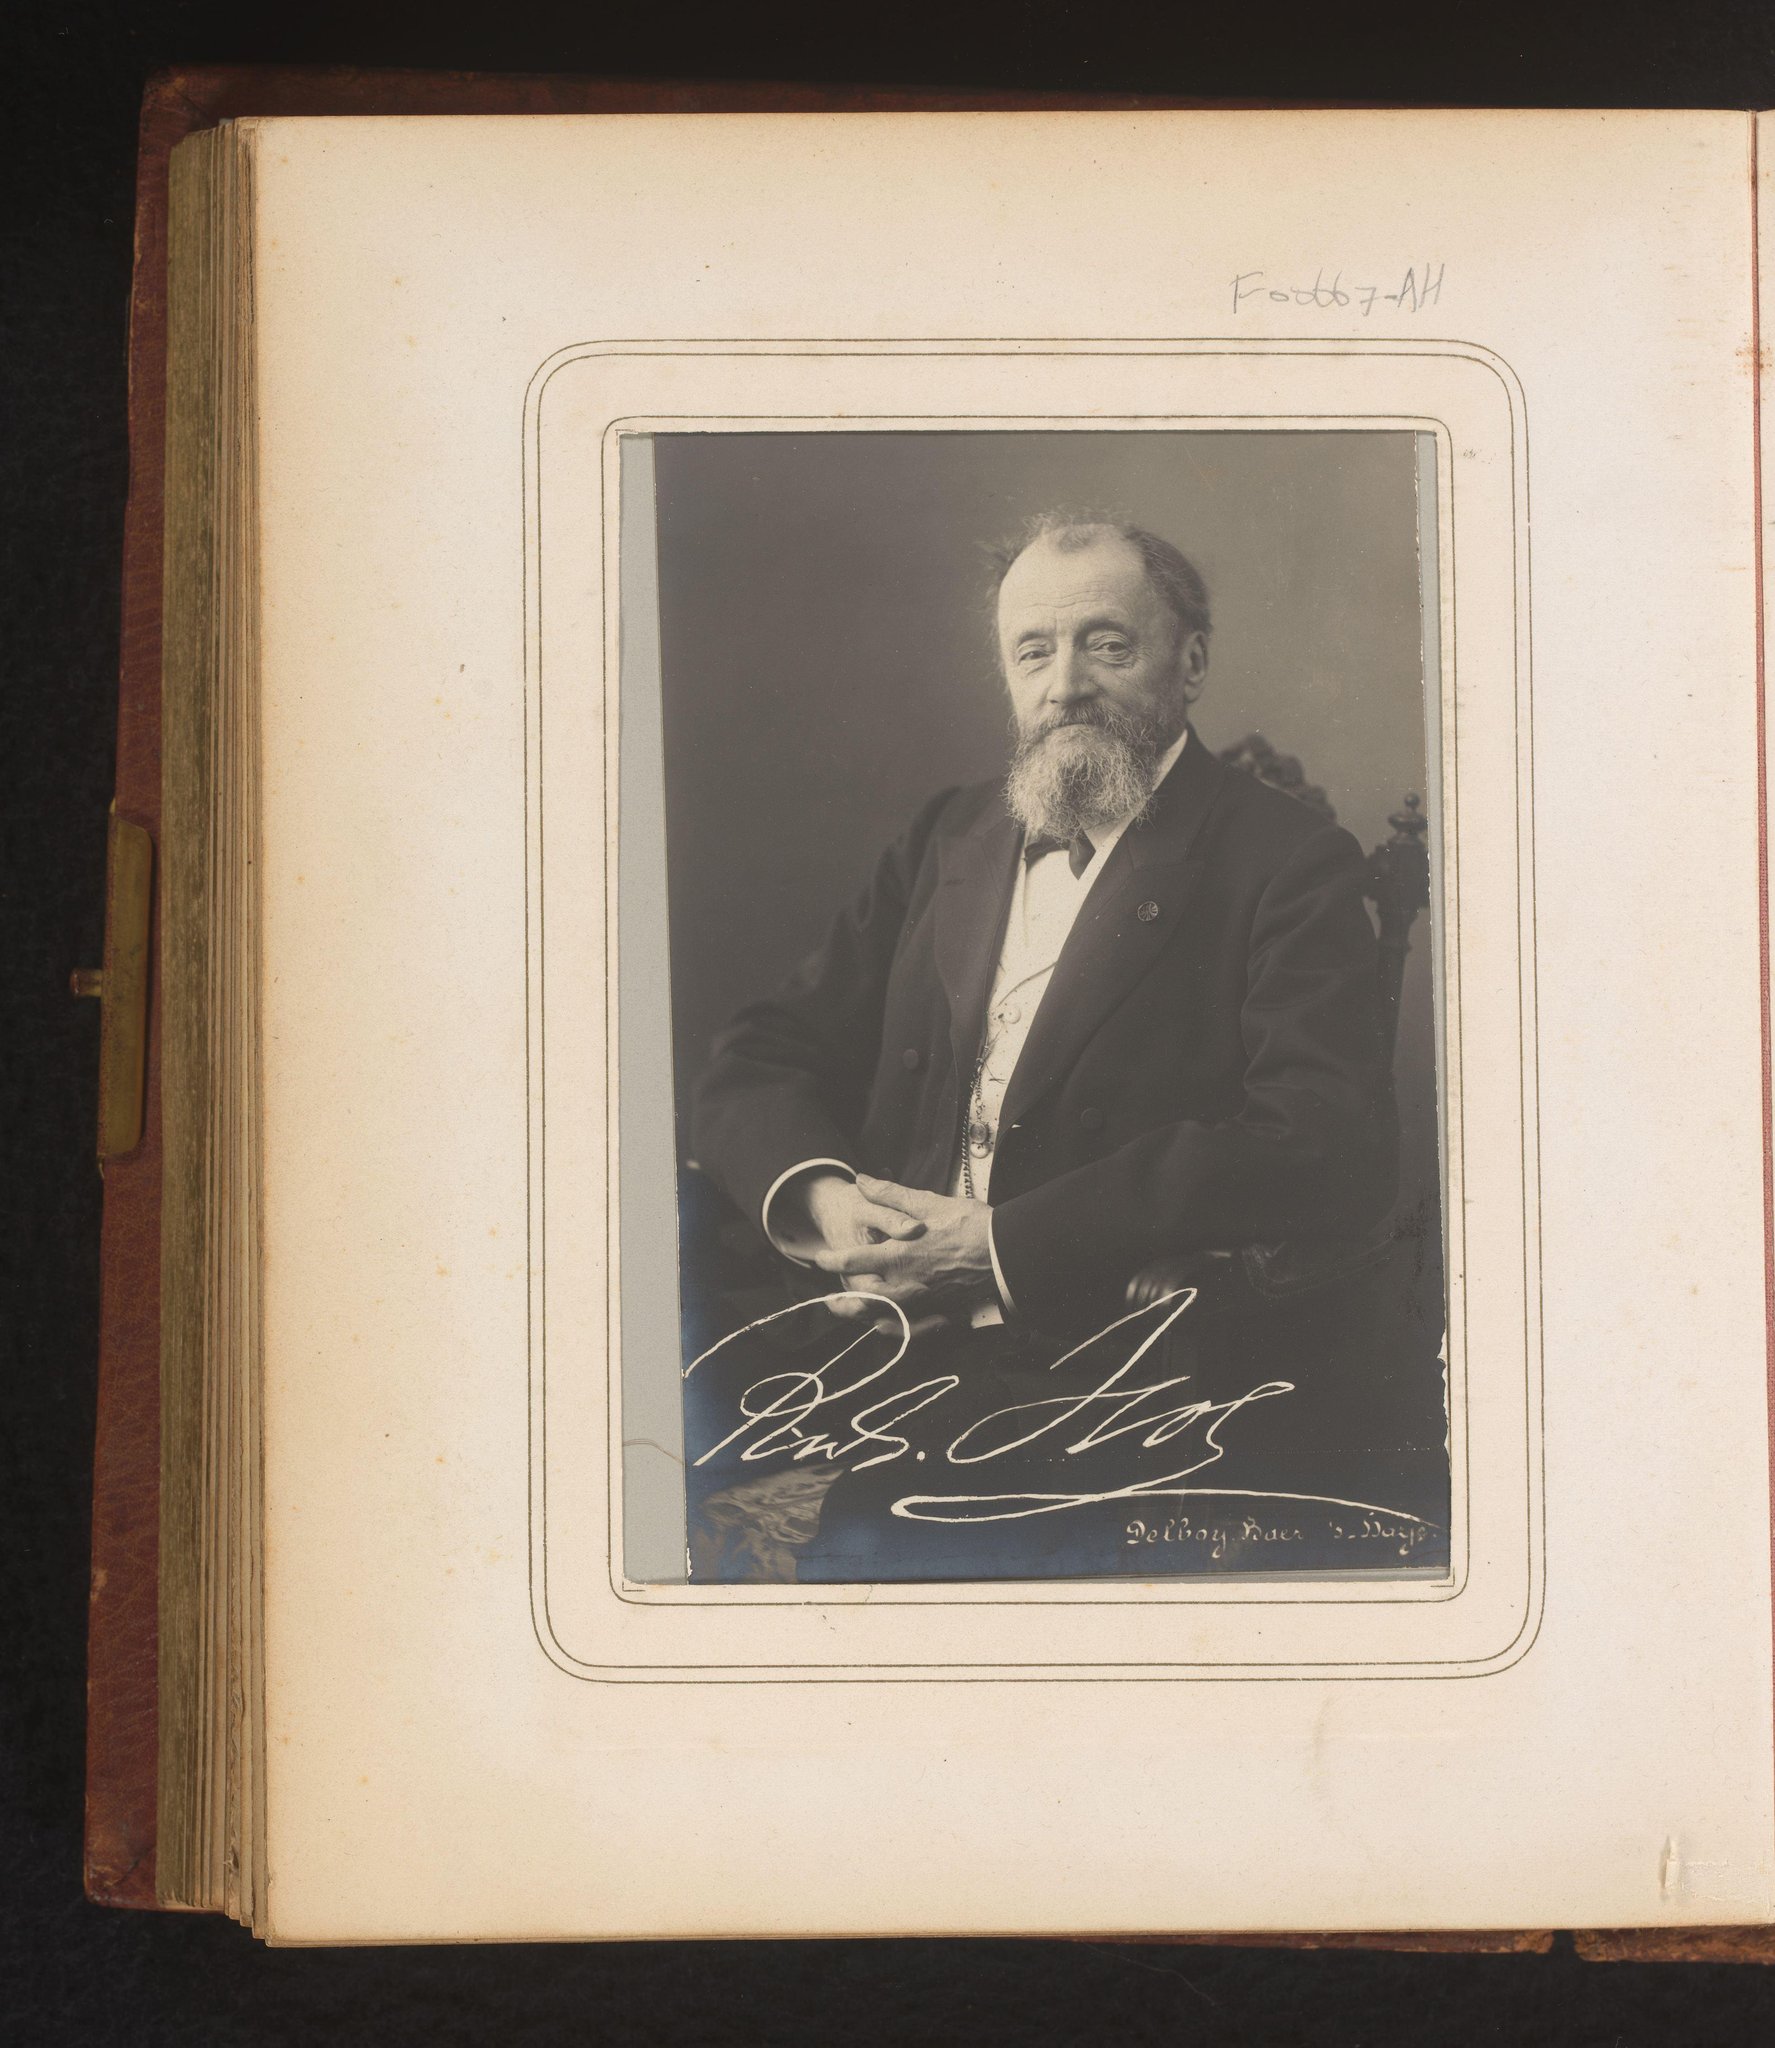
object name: album leaf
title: Portret van een man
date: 1900-1920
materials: cardboard, photographic support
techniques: gelatin silver print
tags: adult man, historical persons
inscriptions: name: ‘[...]’